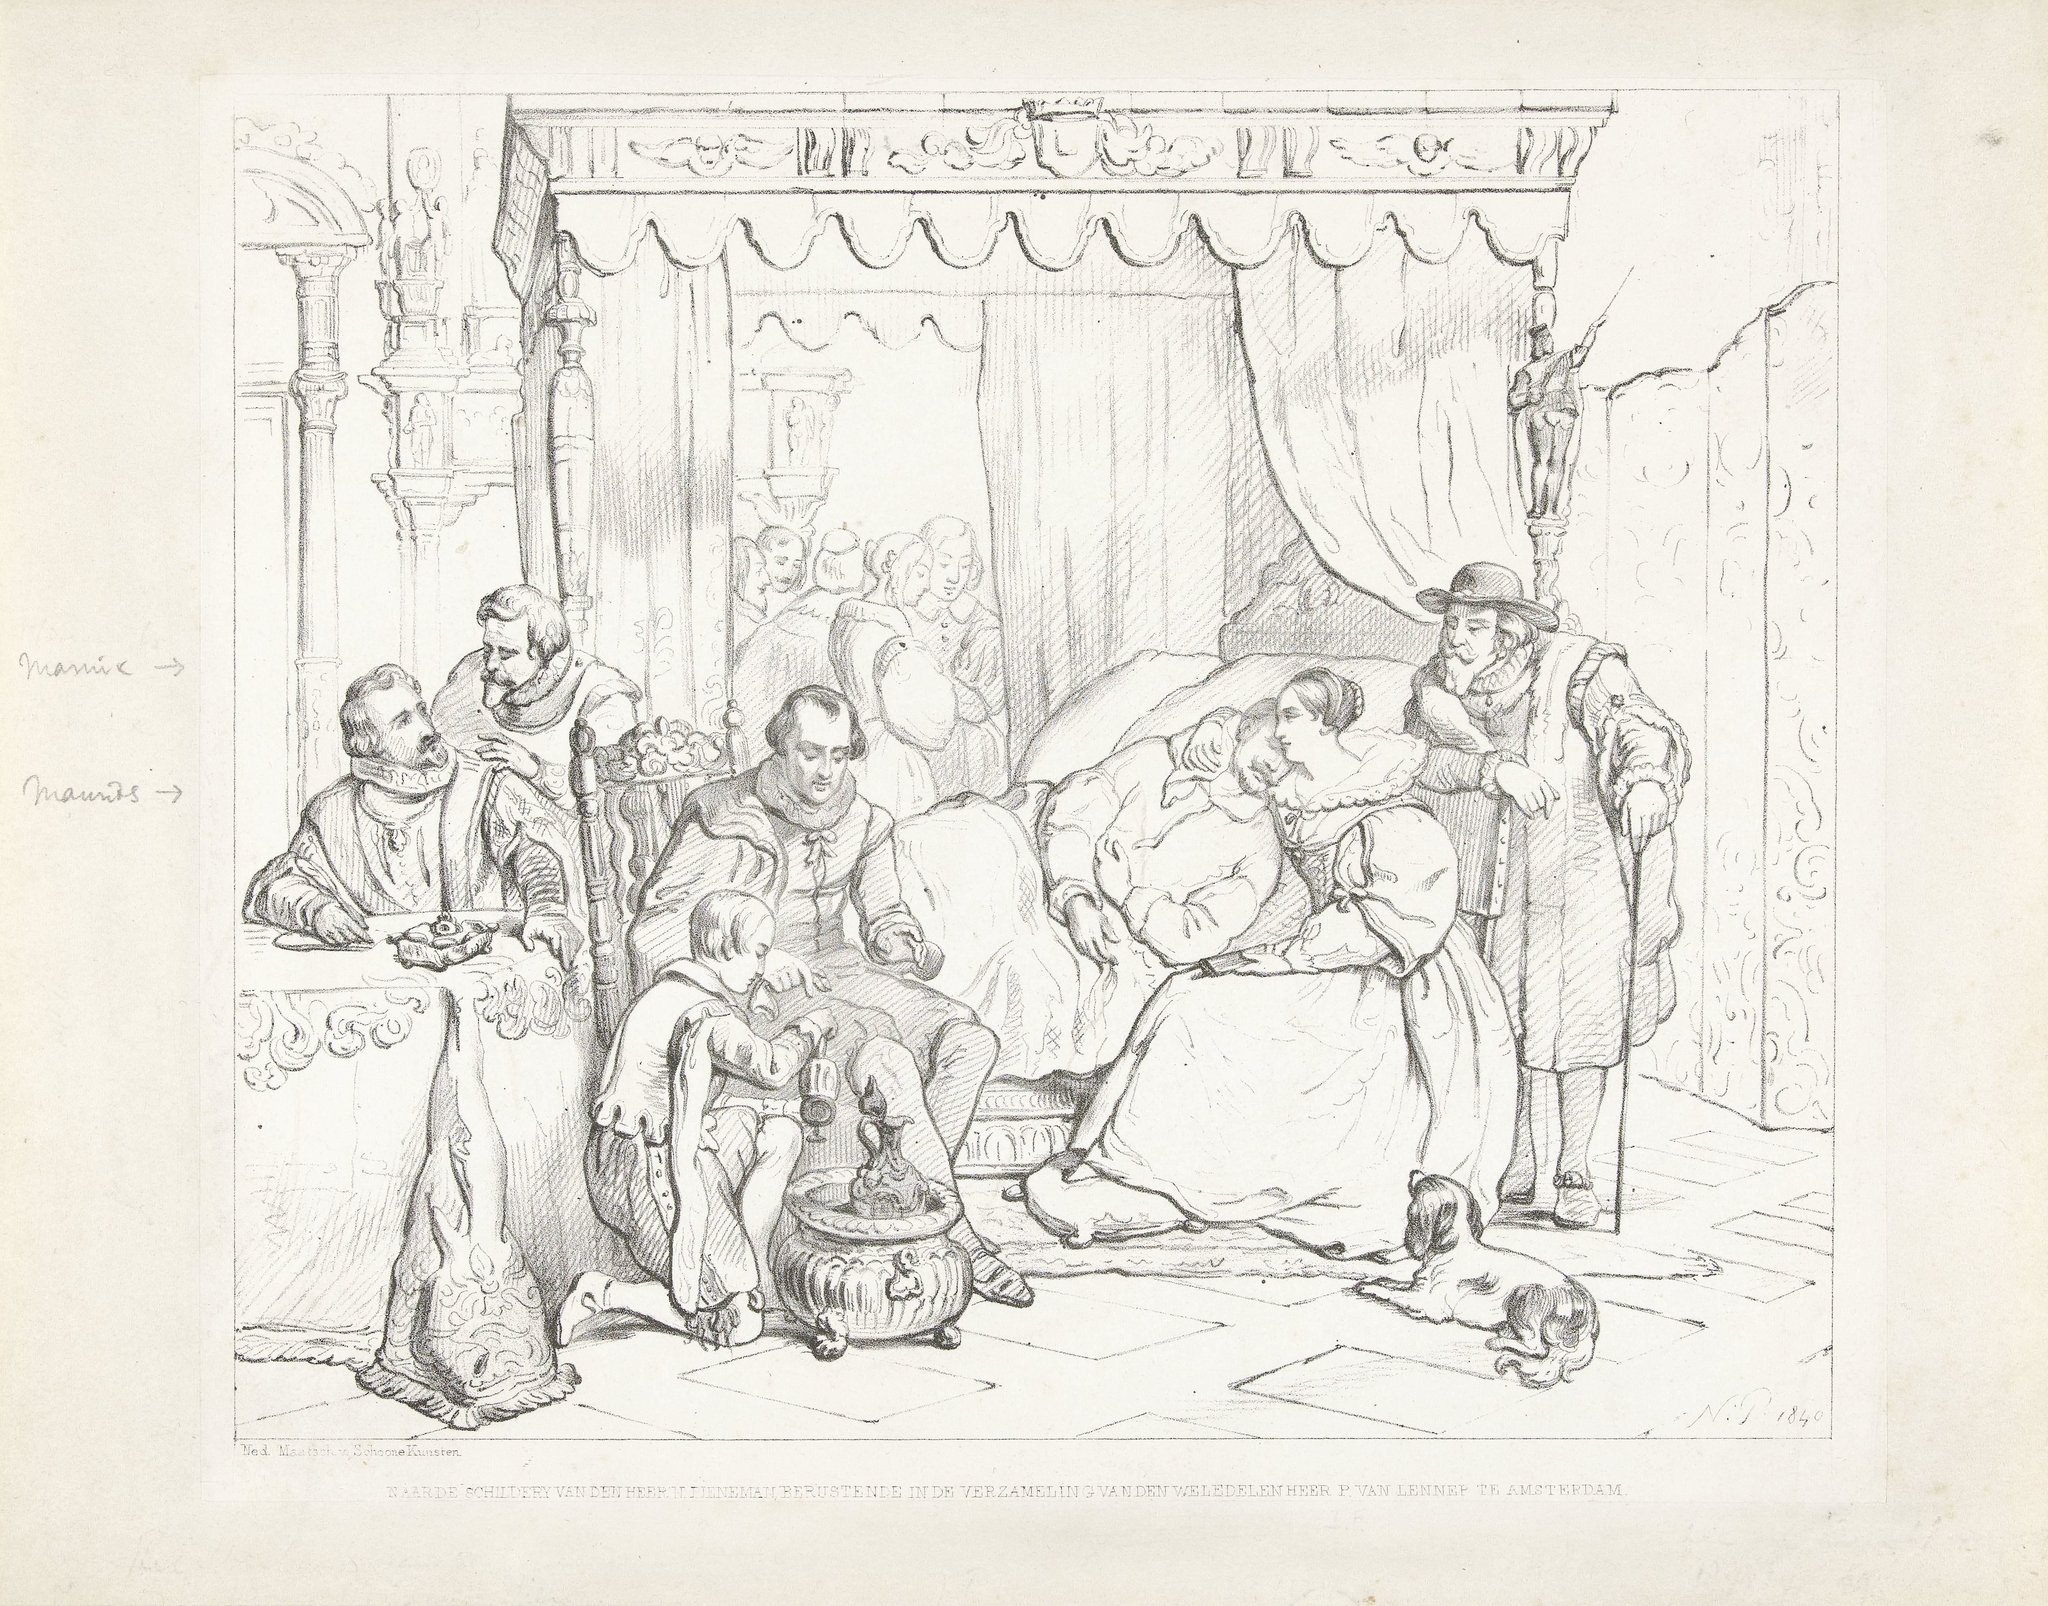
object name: history print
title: Prins Willem I, na de mislukte moordaanslag door Jean Jauregui in 1582, verpleegd door Charlotte de Bourbon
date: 1840-1843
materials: paper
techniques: lithograph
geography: netherlands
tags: antwerp, charlotte of bourbon, delft, william i (prince of orange), attempt, political murder, recovery, convalescence of sick person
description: Prins Willem I herstellend van de aanslag door Jean de Jauregui, gepleegd op 18 maart 1582, te Antwerpen. De prins liggend in bed verzorgd door artsen en getroost door zijn vrouw Charlotte de Bourbon.